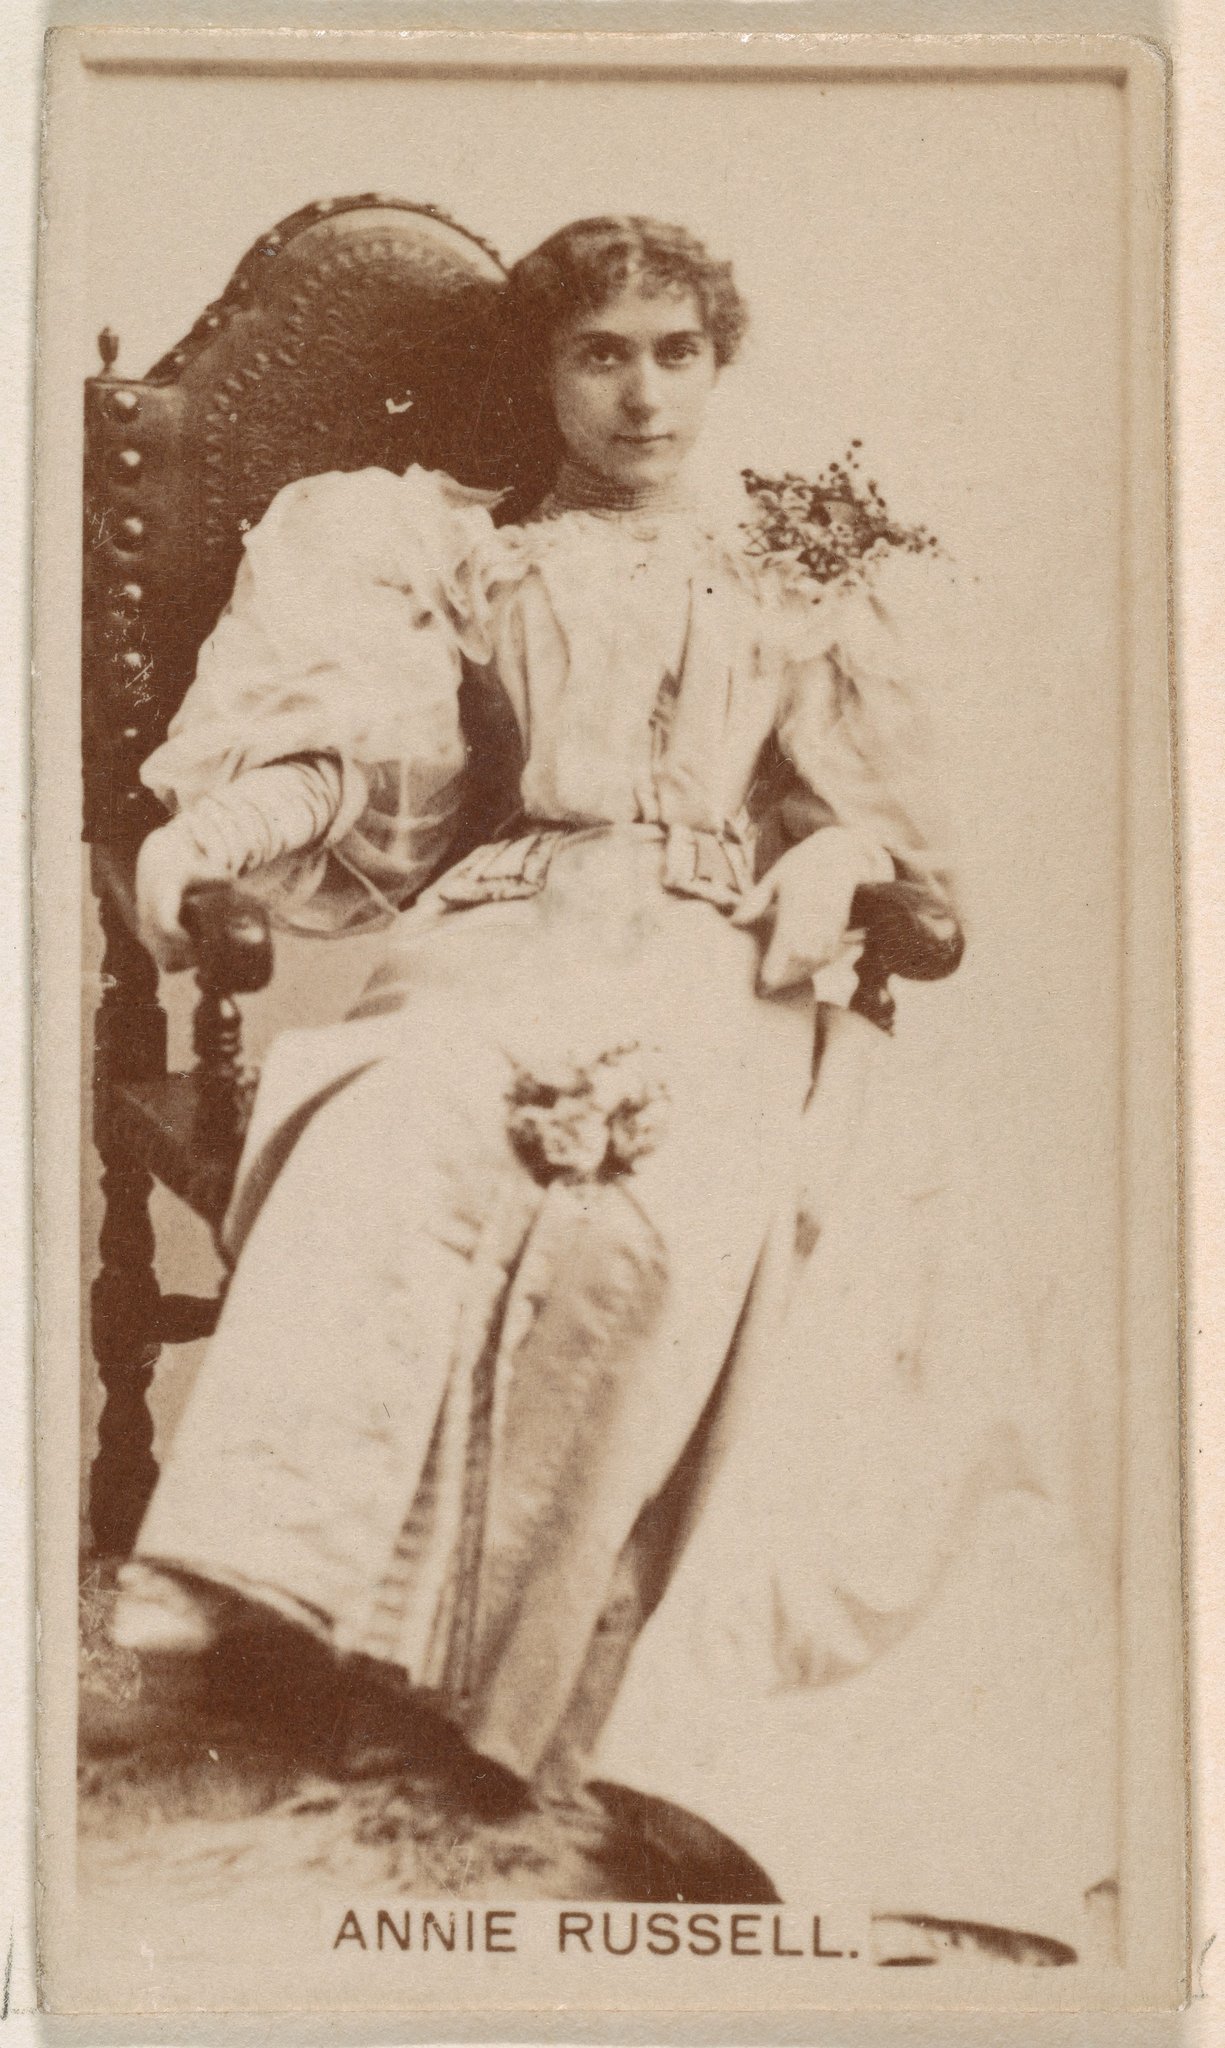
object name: photograph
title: Annie Russell, from the Actresses series (N245) issued by Kinney Brothers to promote Sweet Caporal Cigarettes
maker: kinney brothers tobacco company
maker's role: publisher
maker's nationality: american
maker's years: 1869-2011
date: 1890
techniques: albumen silver print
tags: portraits,women,actresses